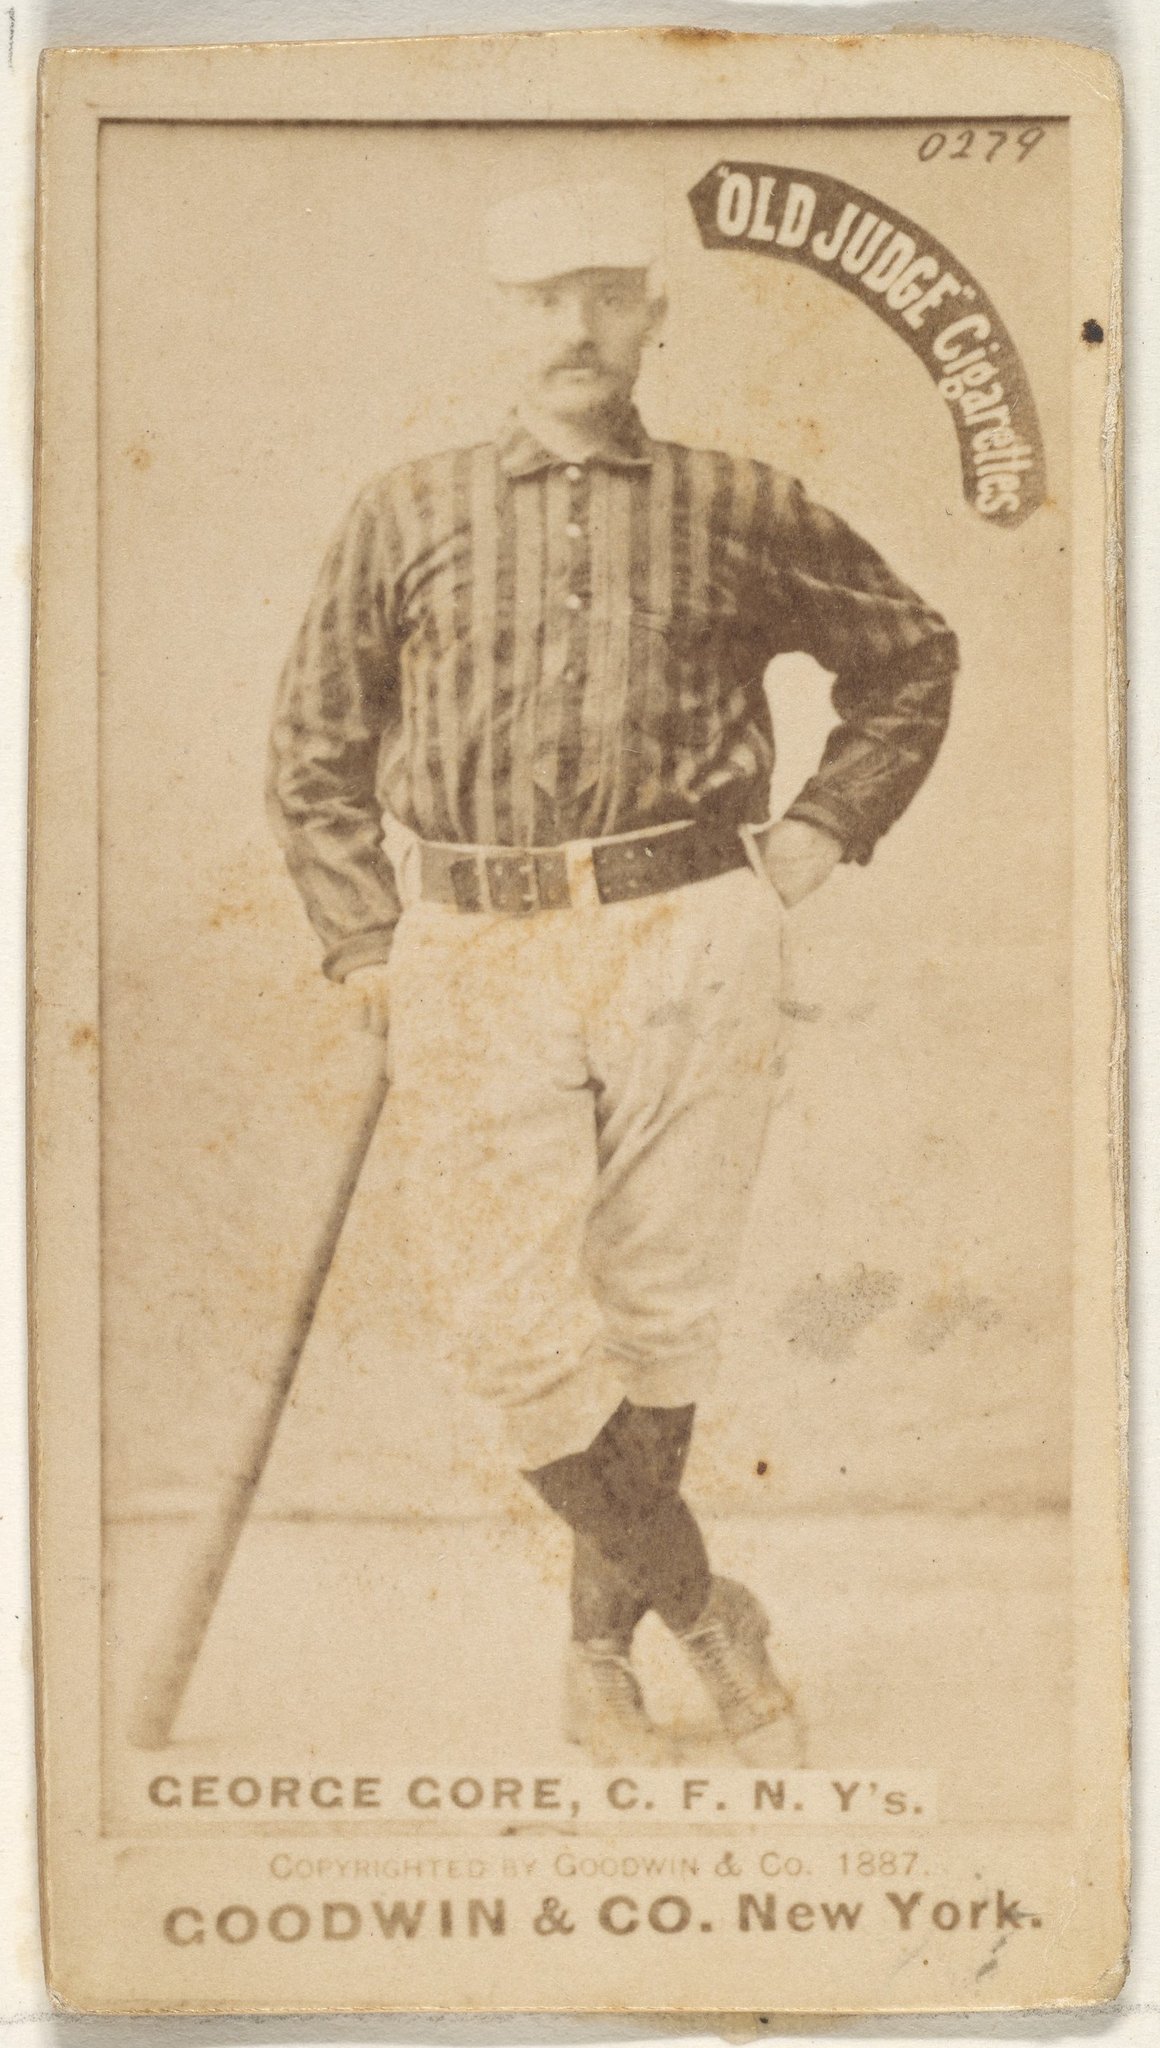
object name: baseball card, photograph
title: George F. "Piano Legs" Gore, Center Field, New York, from the Old Judge series (N172) for Old Judge Cigarettes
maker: goodwin & company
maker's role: publisher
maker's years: 1850-1950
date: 1887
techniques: albumen silver print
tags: men,portraits,baseball,athletes